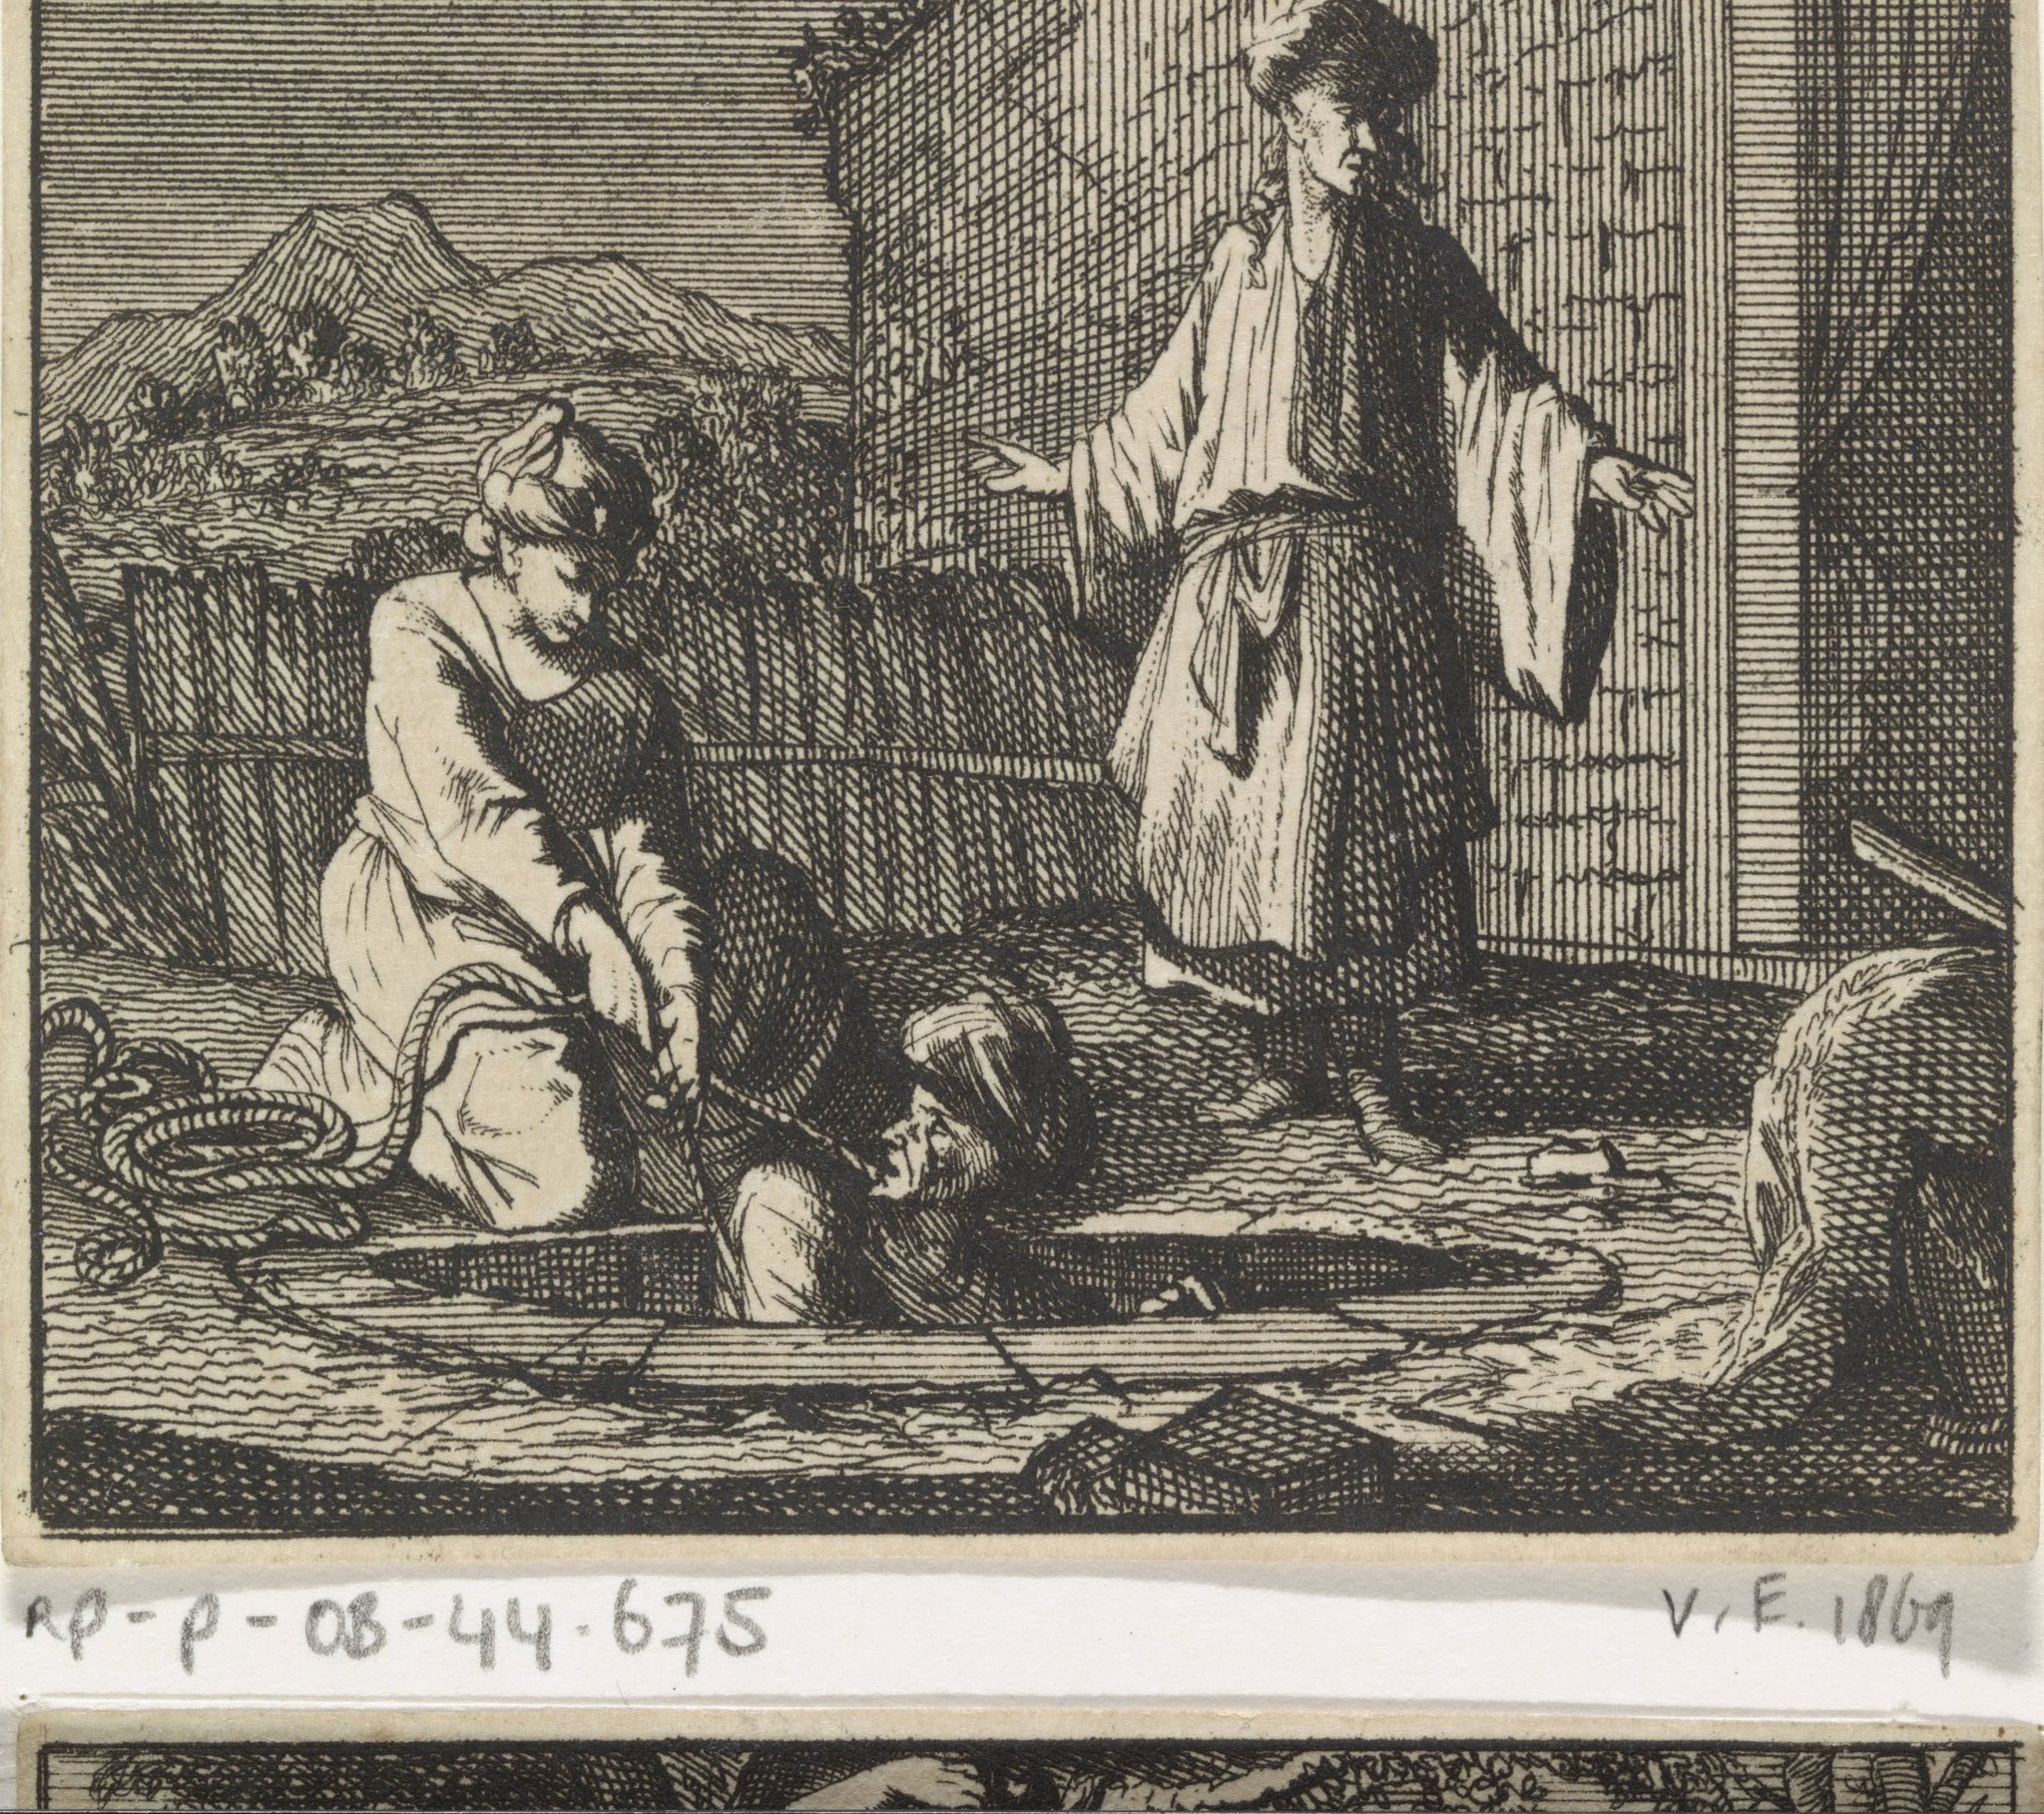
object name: print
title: Jonatan en Achimaäs worden in een put verborgen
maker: caspar luyken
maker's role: draughtsman, print maker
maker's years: 1672-1708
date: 1698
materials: paper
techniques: etching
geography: amsterdam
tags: pursued by absalom's soldiers ahimaaz and jonathan hide in a pit in a house at baharim; a woman spreads a cover with corn over the pit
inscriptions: collector's mark: Lugt 2228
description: Proefdruk van illustratie uit: Josephus, Flavius. XX. boeken van de oude geschiedenissen der joden, 4 delen. Amsterdam: Barent Visscher, Willem de Coup, Willem van Lamsveld, Andries van Damme, 1698, dl. I.